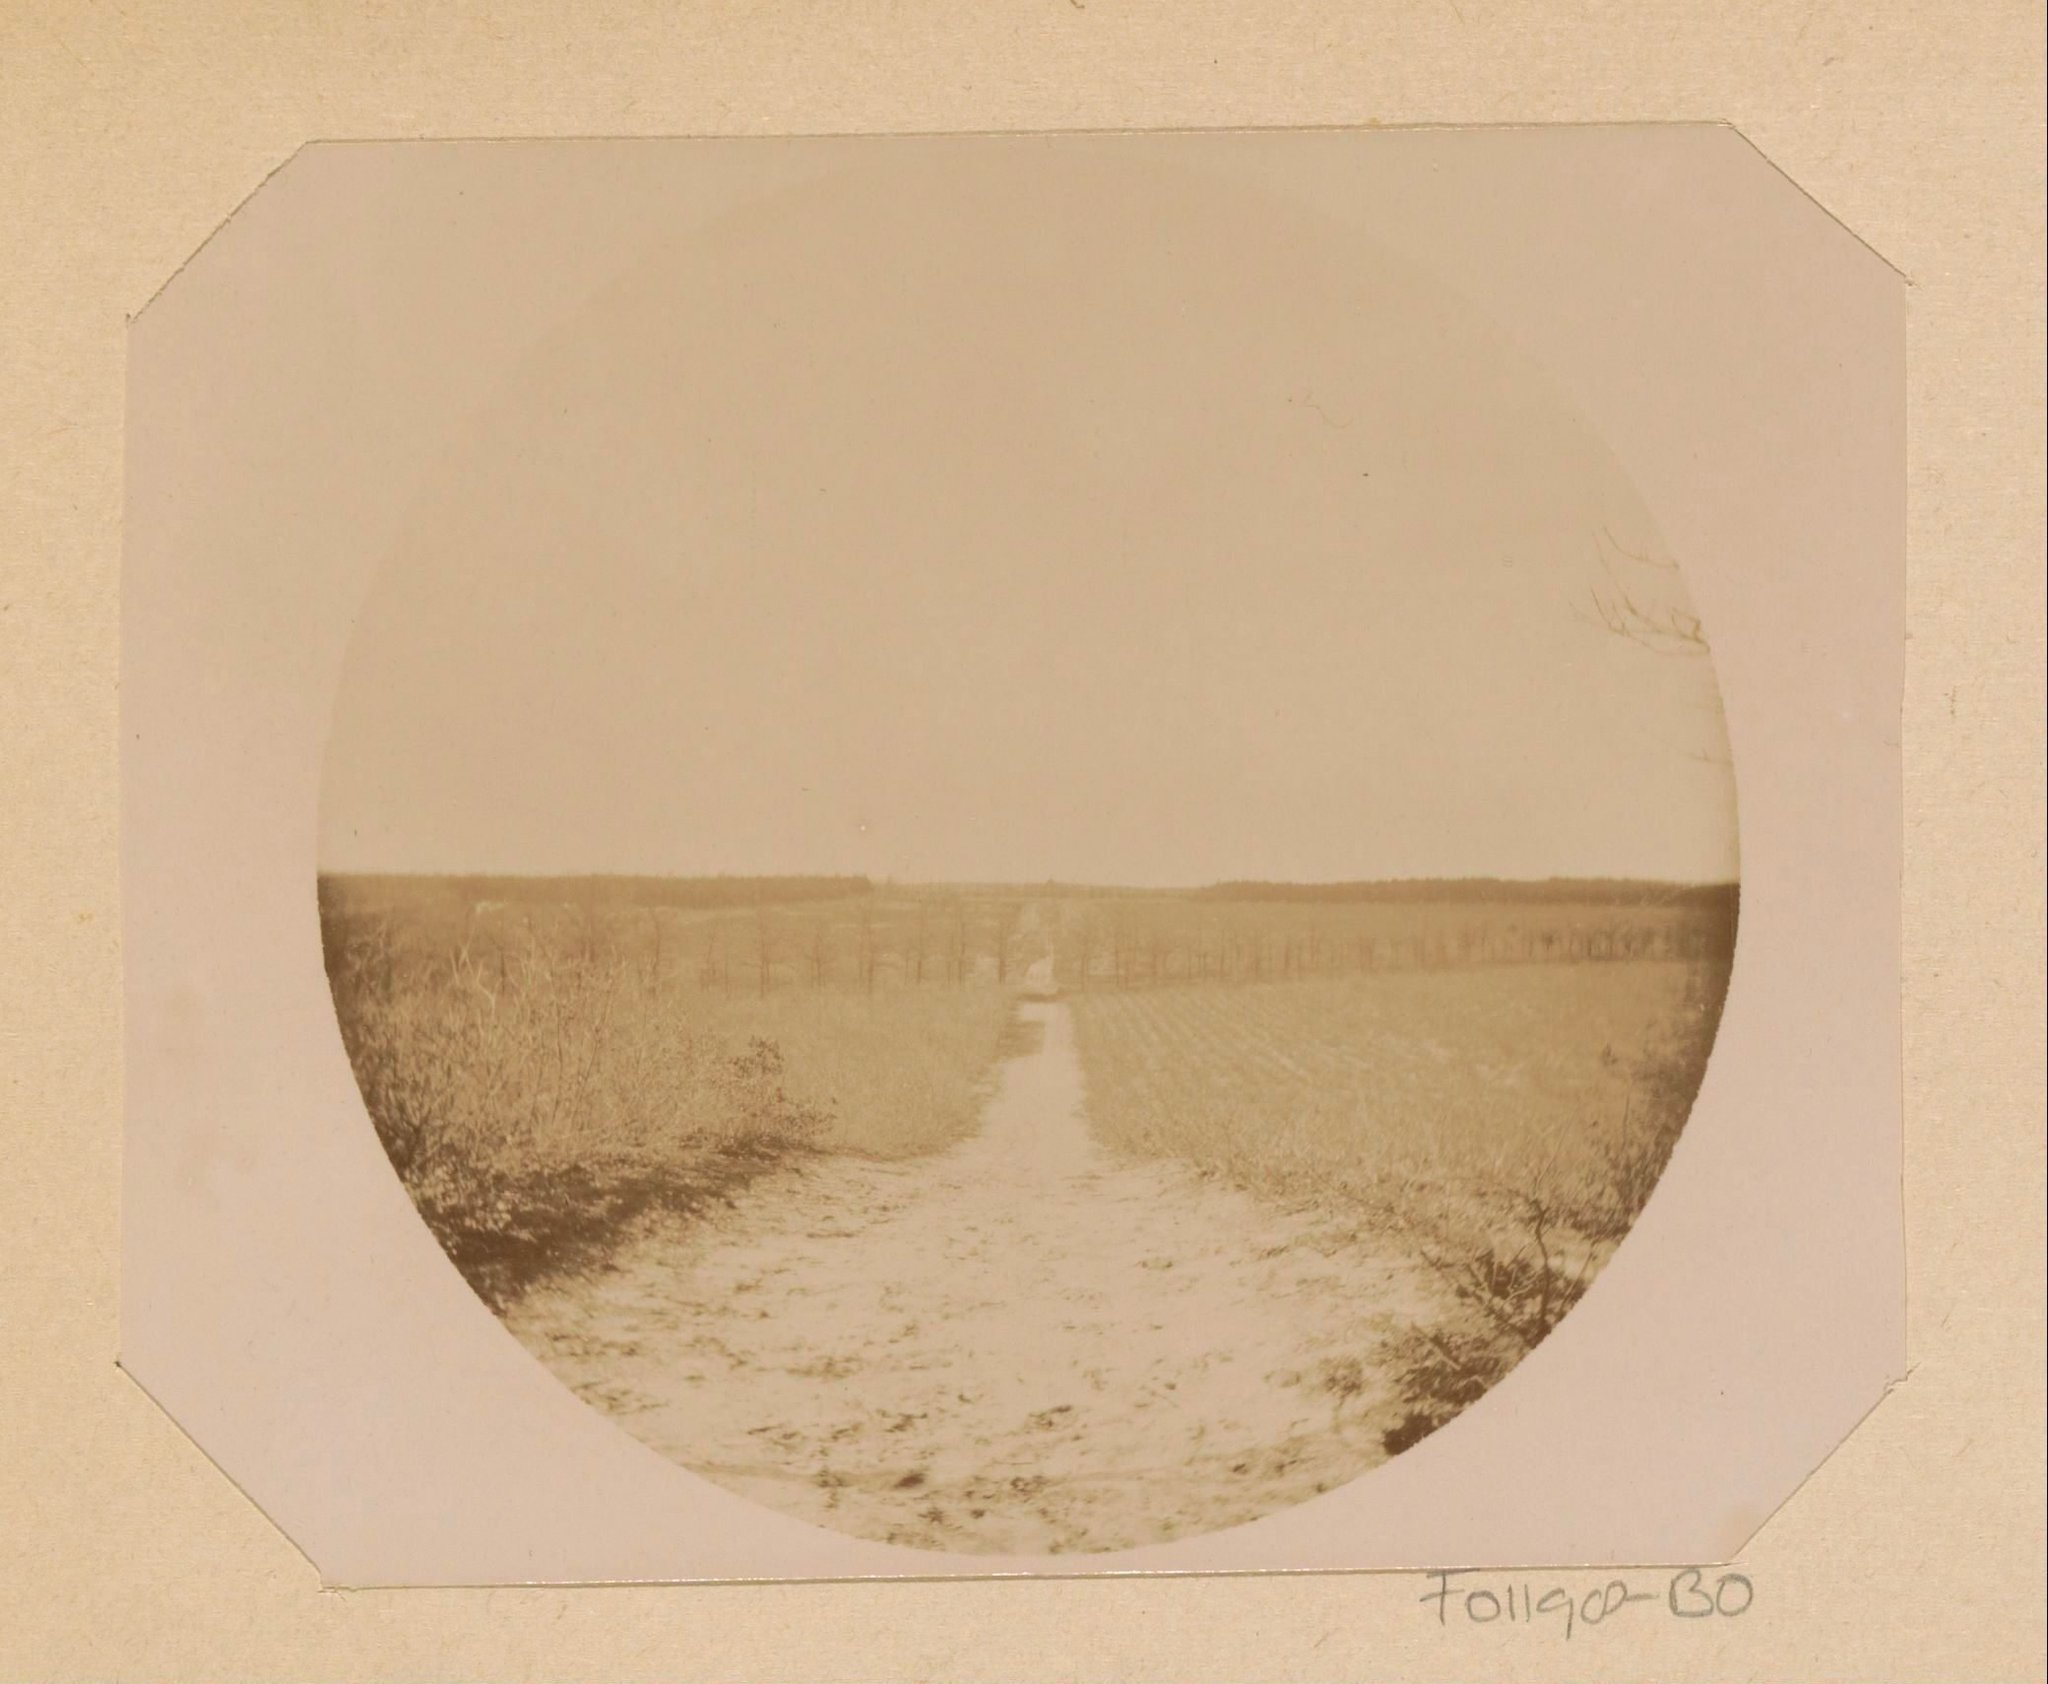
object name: album leaf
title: Pad door akkers nabij Arnhem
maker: johanna margaretha piek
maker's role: fotograaf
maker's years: 1870-1947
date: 1889-1893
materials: paper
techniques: gelatin silver print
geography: arnhem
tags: forest path or lane, arnhem